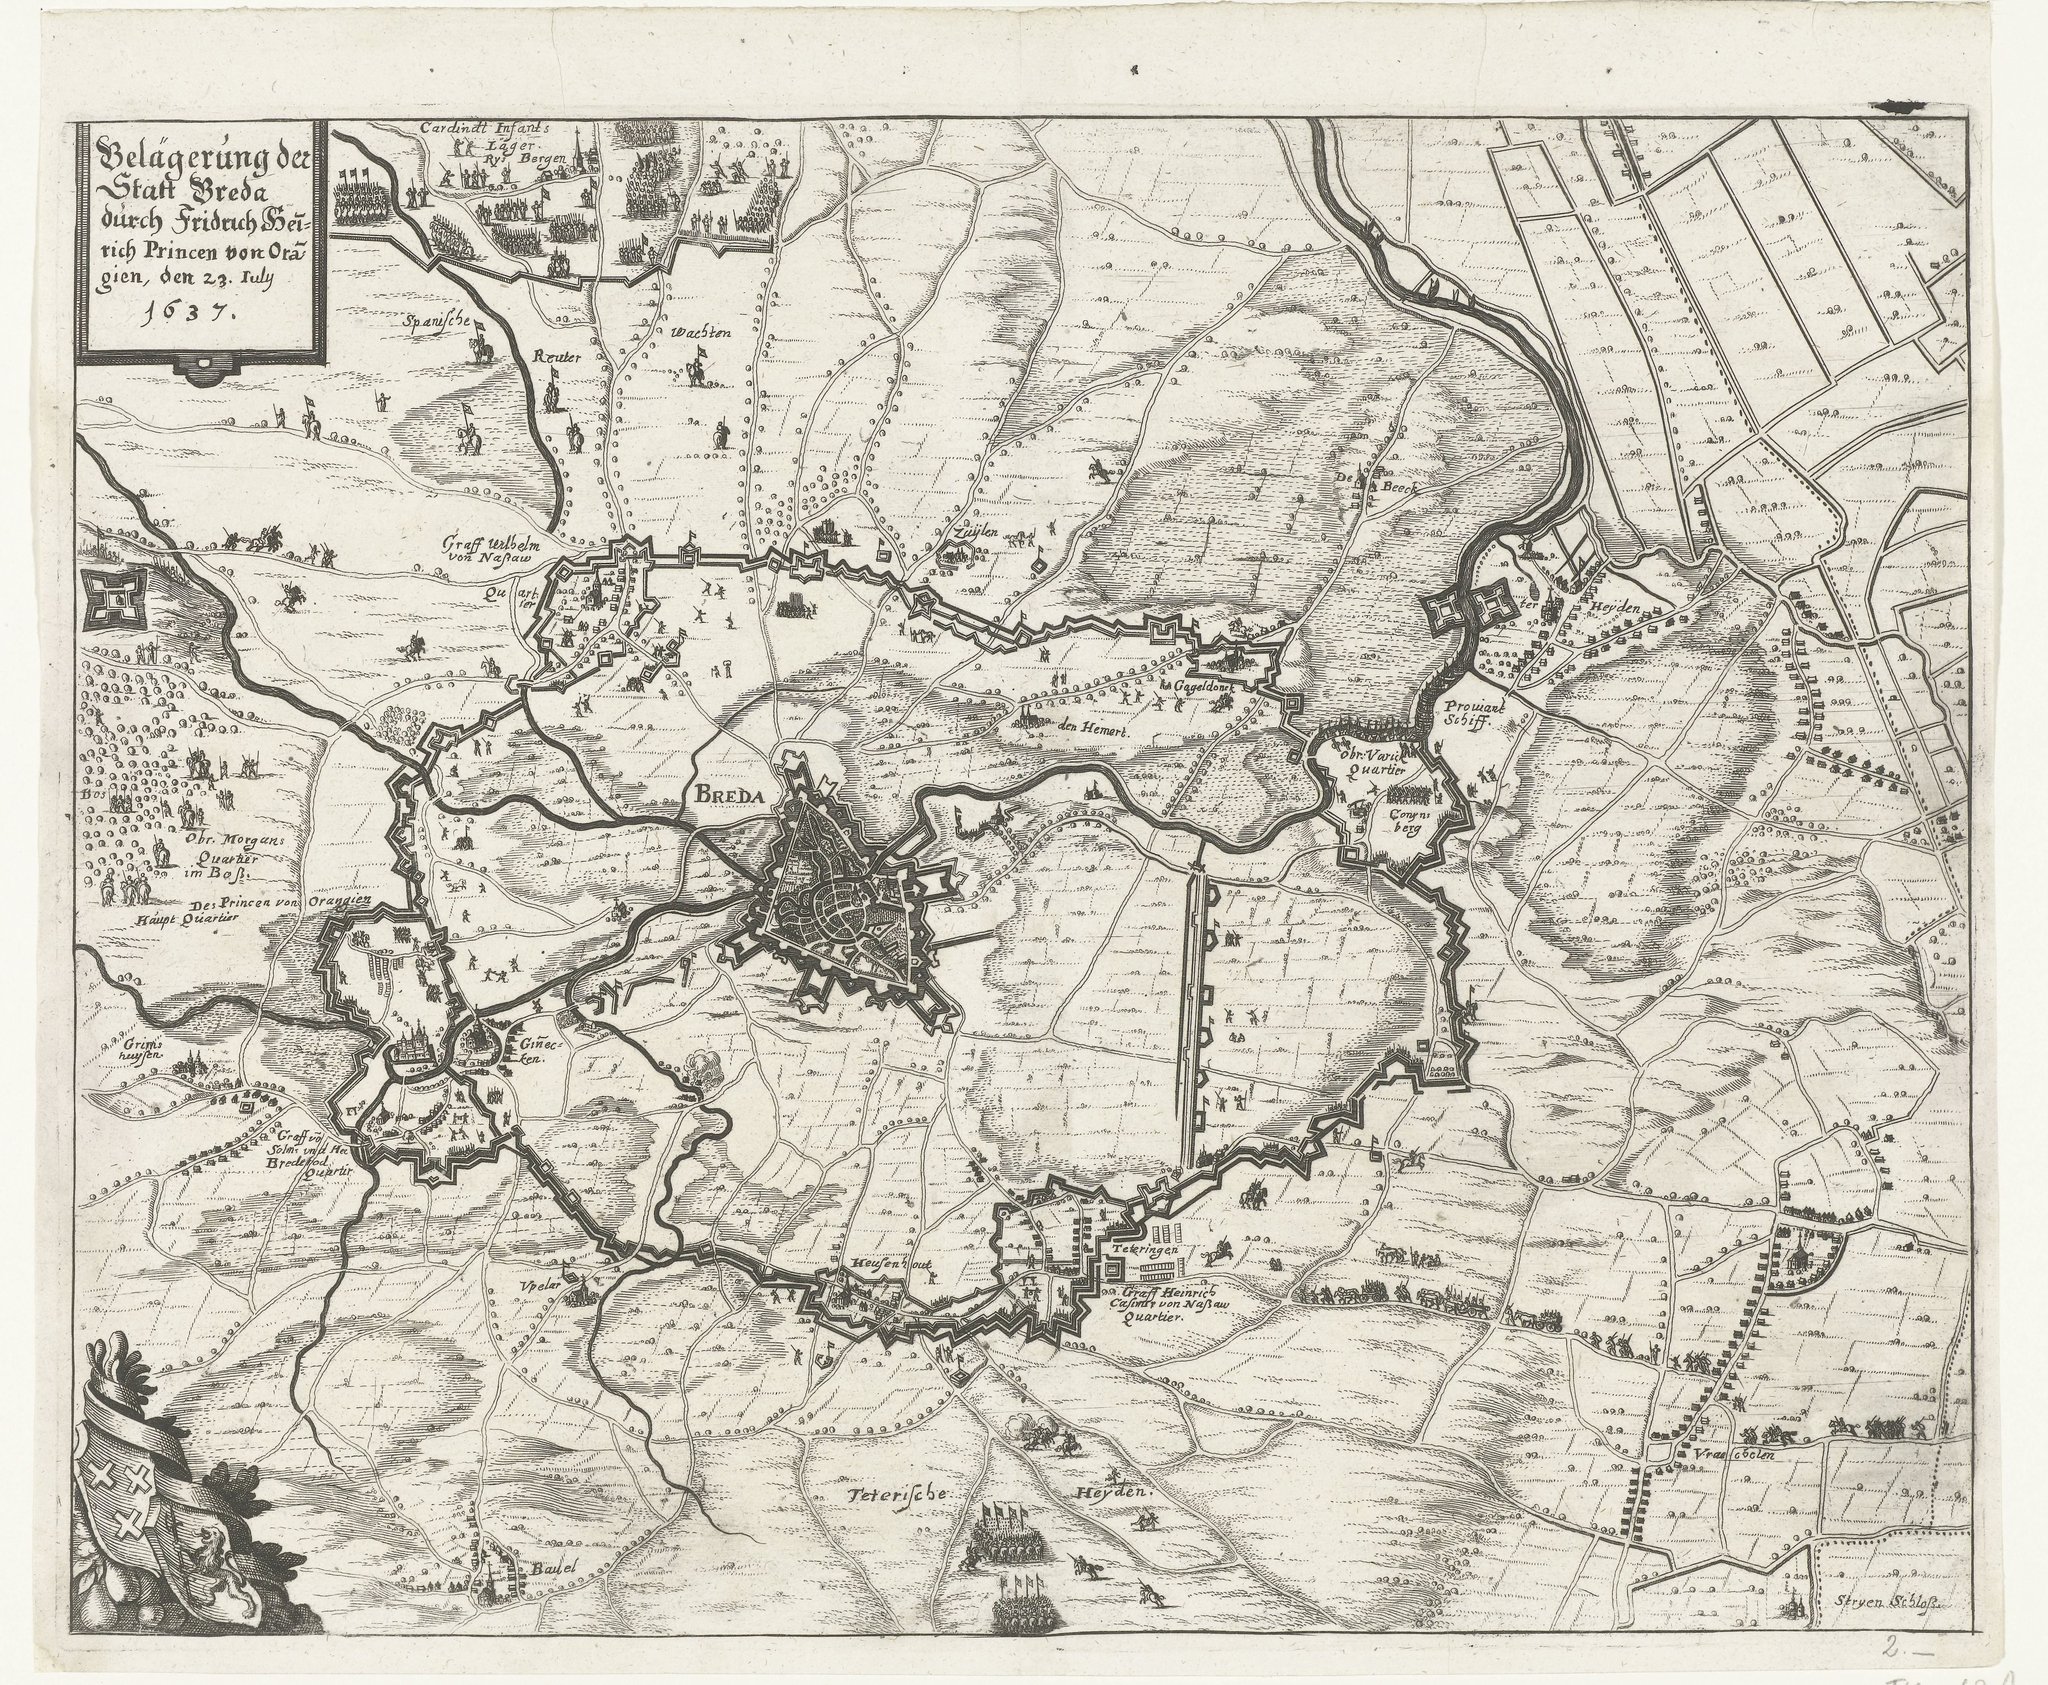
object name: print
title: Beleg van Breda, 1637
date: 1651-1659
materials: paper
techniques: etching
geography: germany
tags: the hague, frederick henry (prince of orange), maps of separate countries or regions, siege, position war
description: Anonieme Duitse kopie naar de prent mogelijk door P.H. Schut (gekopieerd naar de prent van C.J. Visscher, FMH 1766) in I. Commelin, Frederick Hendrick van Nassauw Prince van Orangien : zyn leven en bedryf, Jodocus Janssonius, Amsterdam 1651 (FMH 1767). Niet in Frederik Muller; door het RPK toegevoegd nummer.